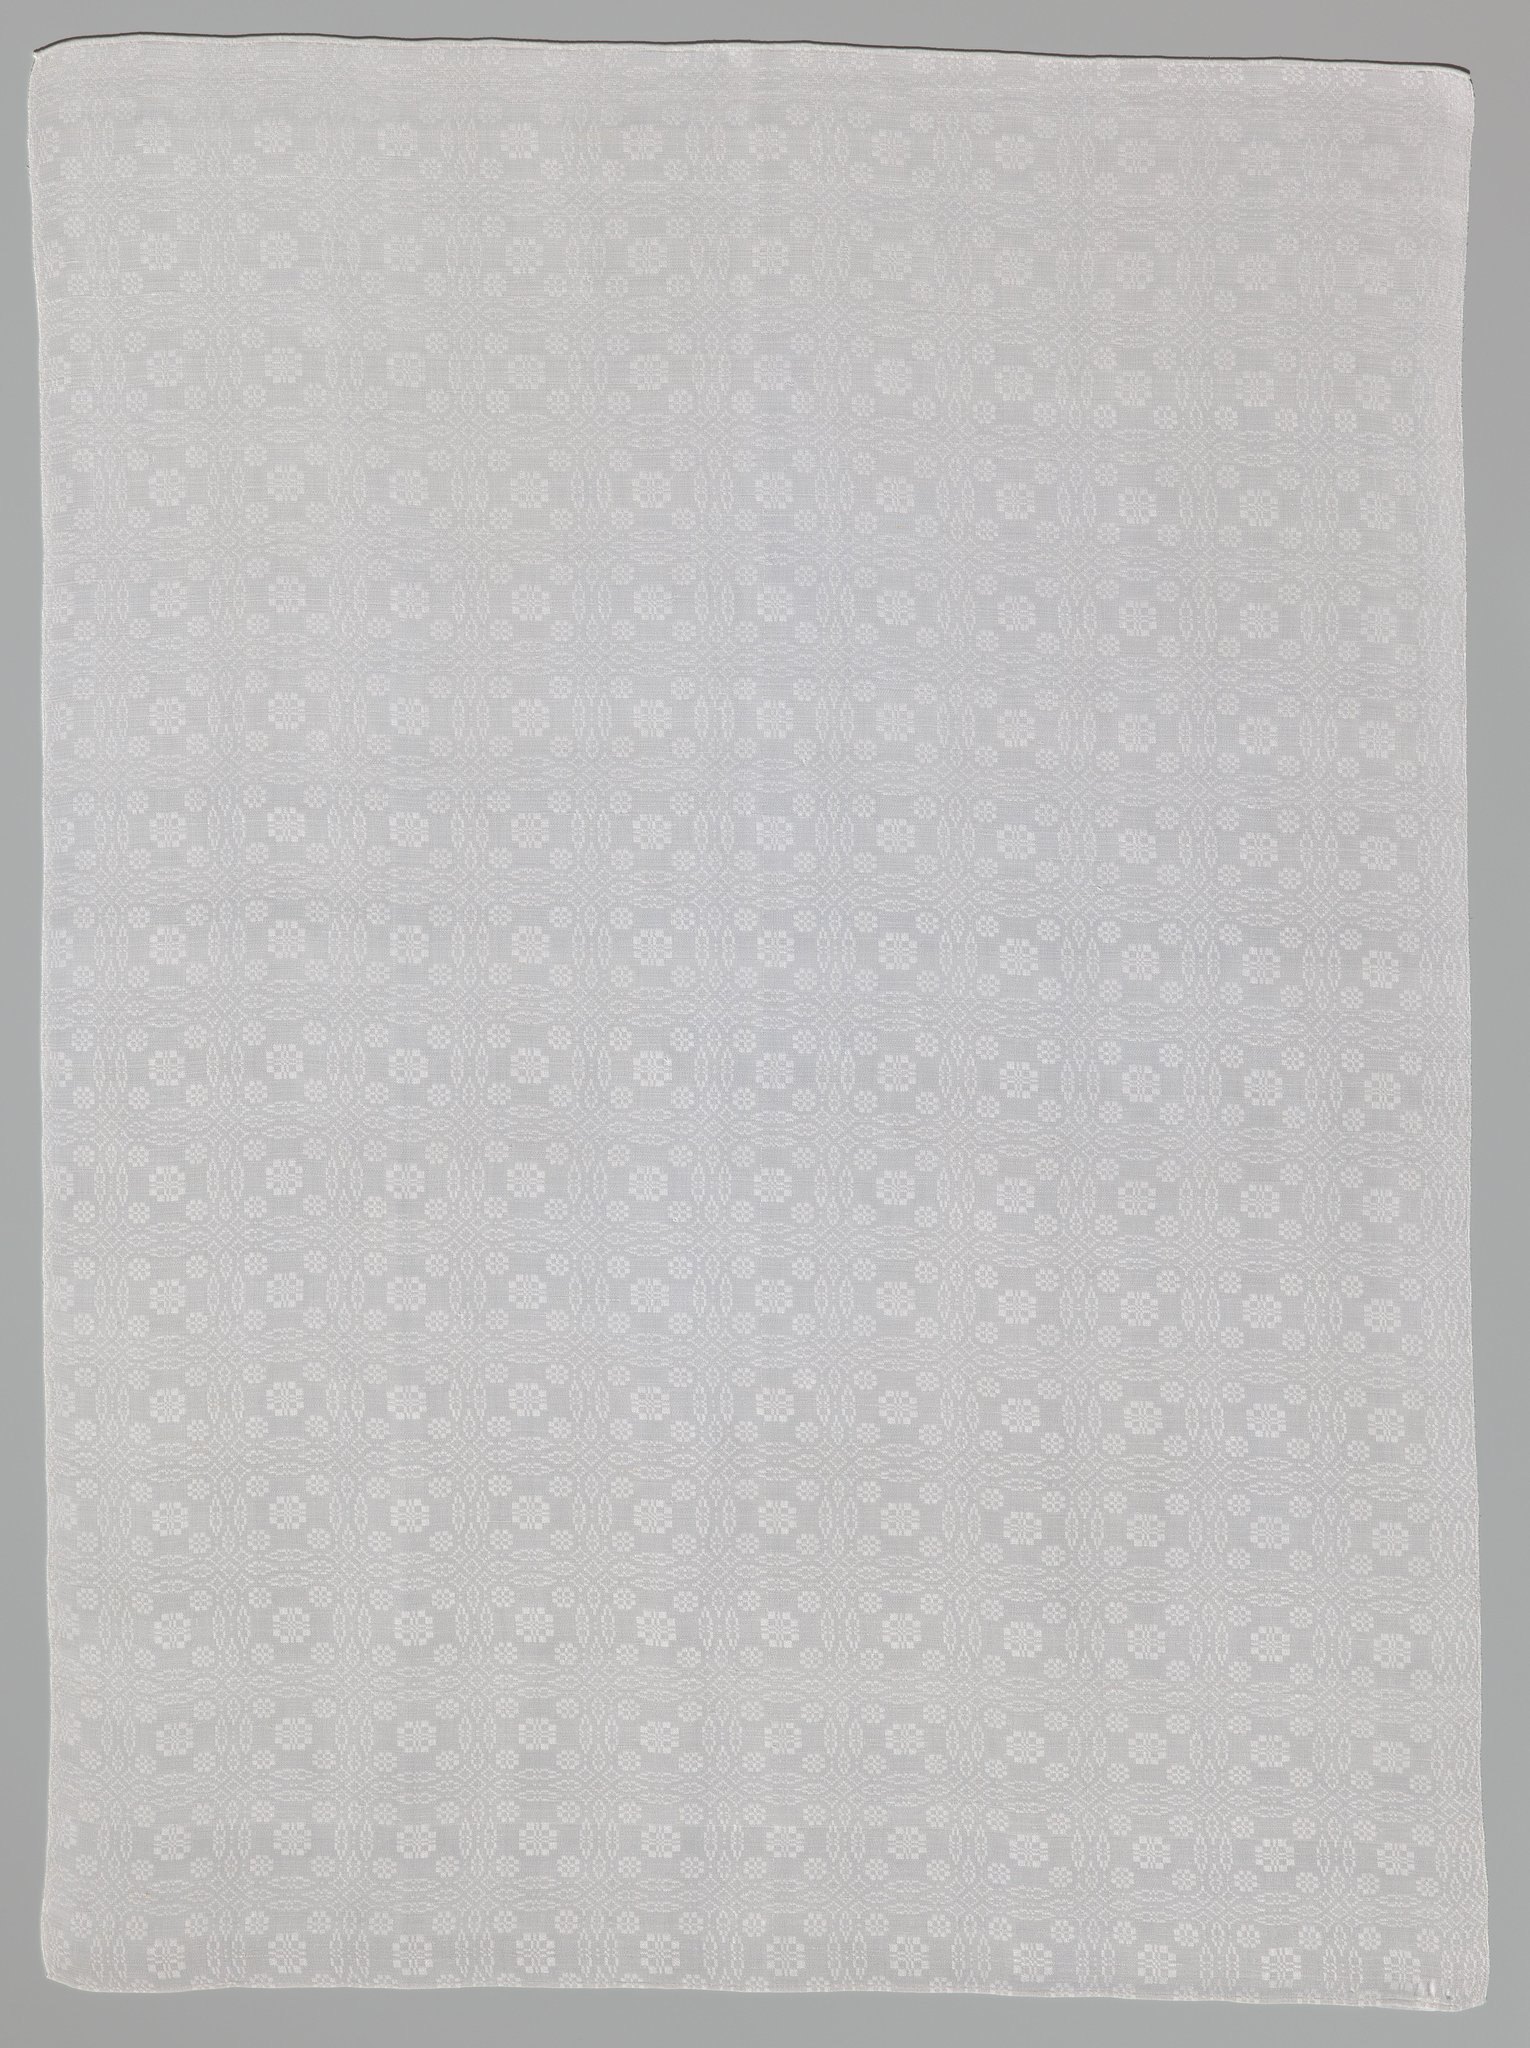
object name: napkin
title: Servet van linnen met pellenpatroon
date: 1690-1725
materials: linen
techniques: peeled fabric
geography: northern netherlands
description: wit linnen servet met pellen patroon, merk IB 50